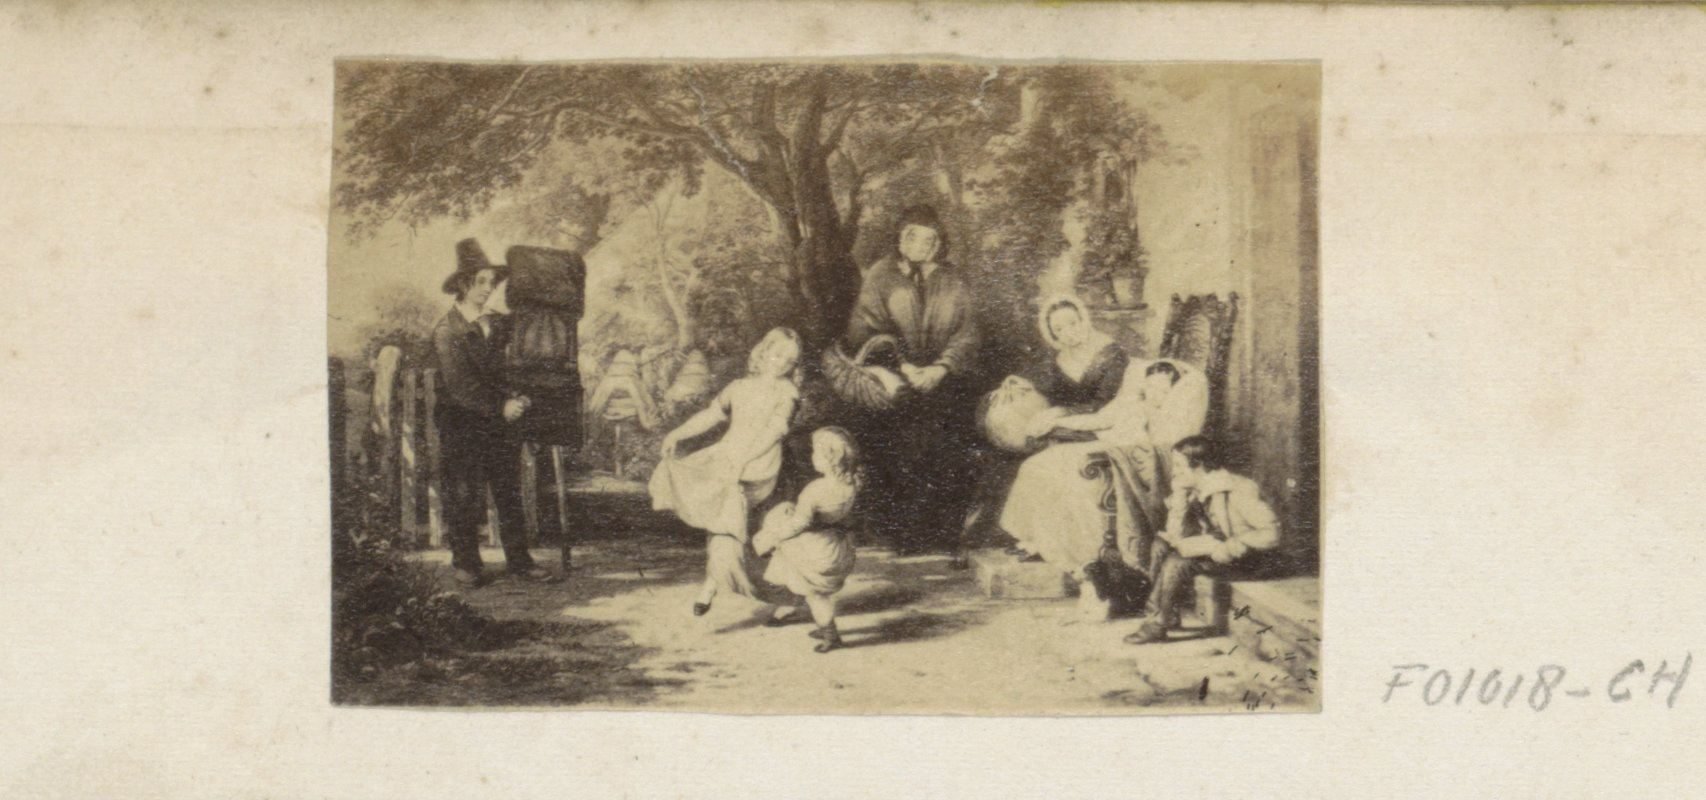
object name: reproduction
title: Fotoreproductie van (vermoedelijk) een prent met een speelman en dansende kinderen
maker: Anonymous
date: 1860-1870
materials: paper, photographic support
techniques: albumen print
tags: dancing, child, making music; musician with instrument - cc - out of doors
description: Onderdeel van Engels familiealbum met foto's van personen, reizen, cricket en kunstwerken.